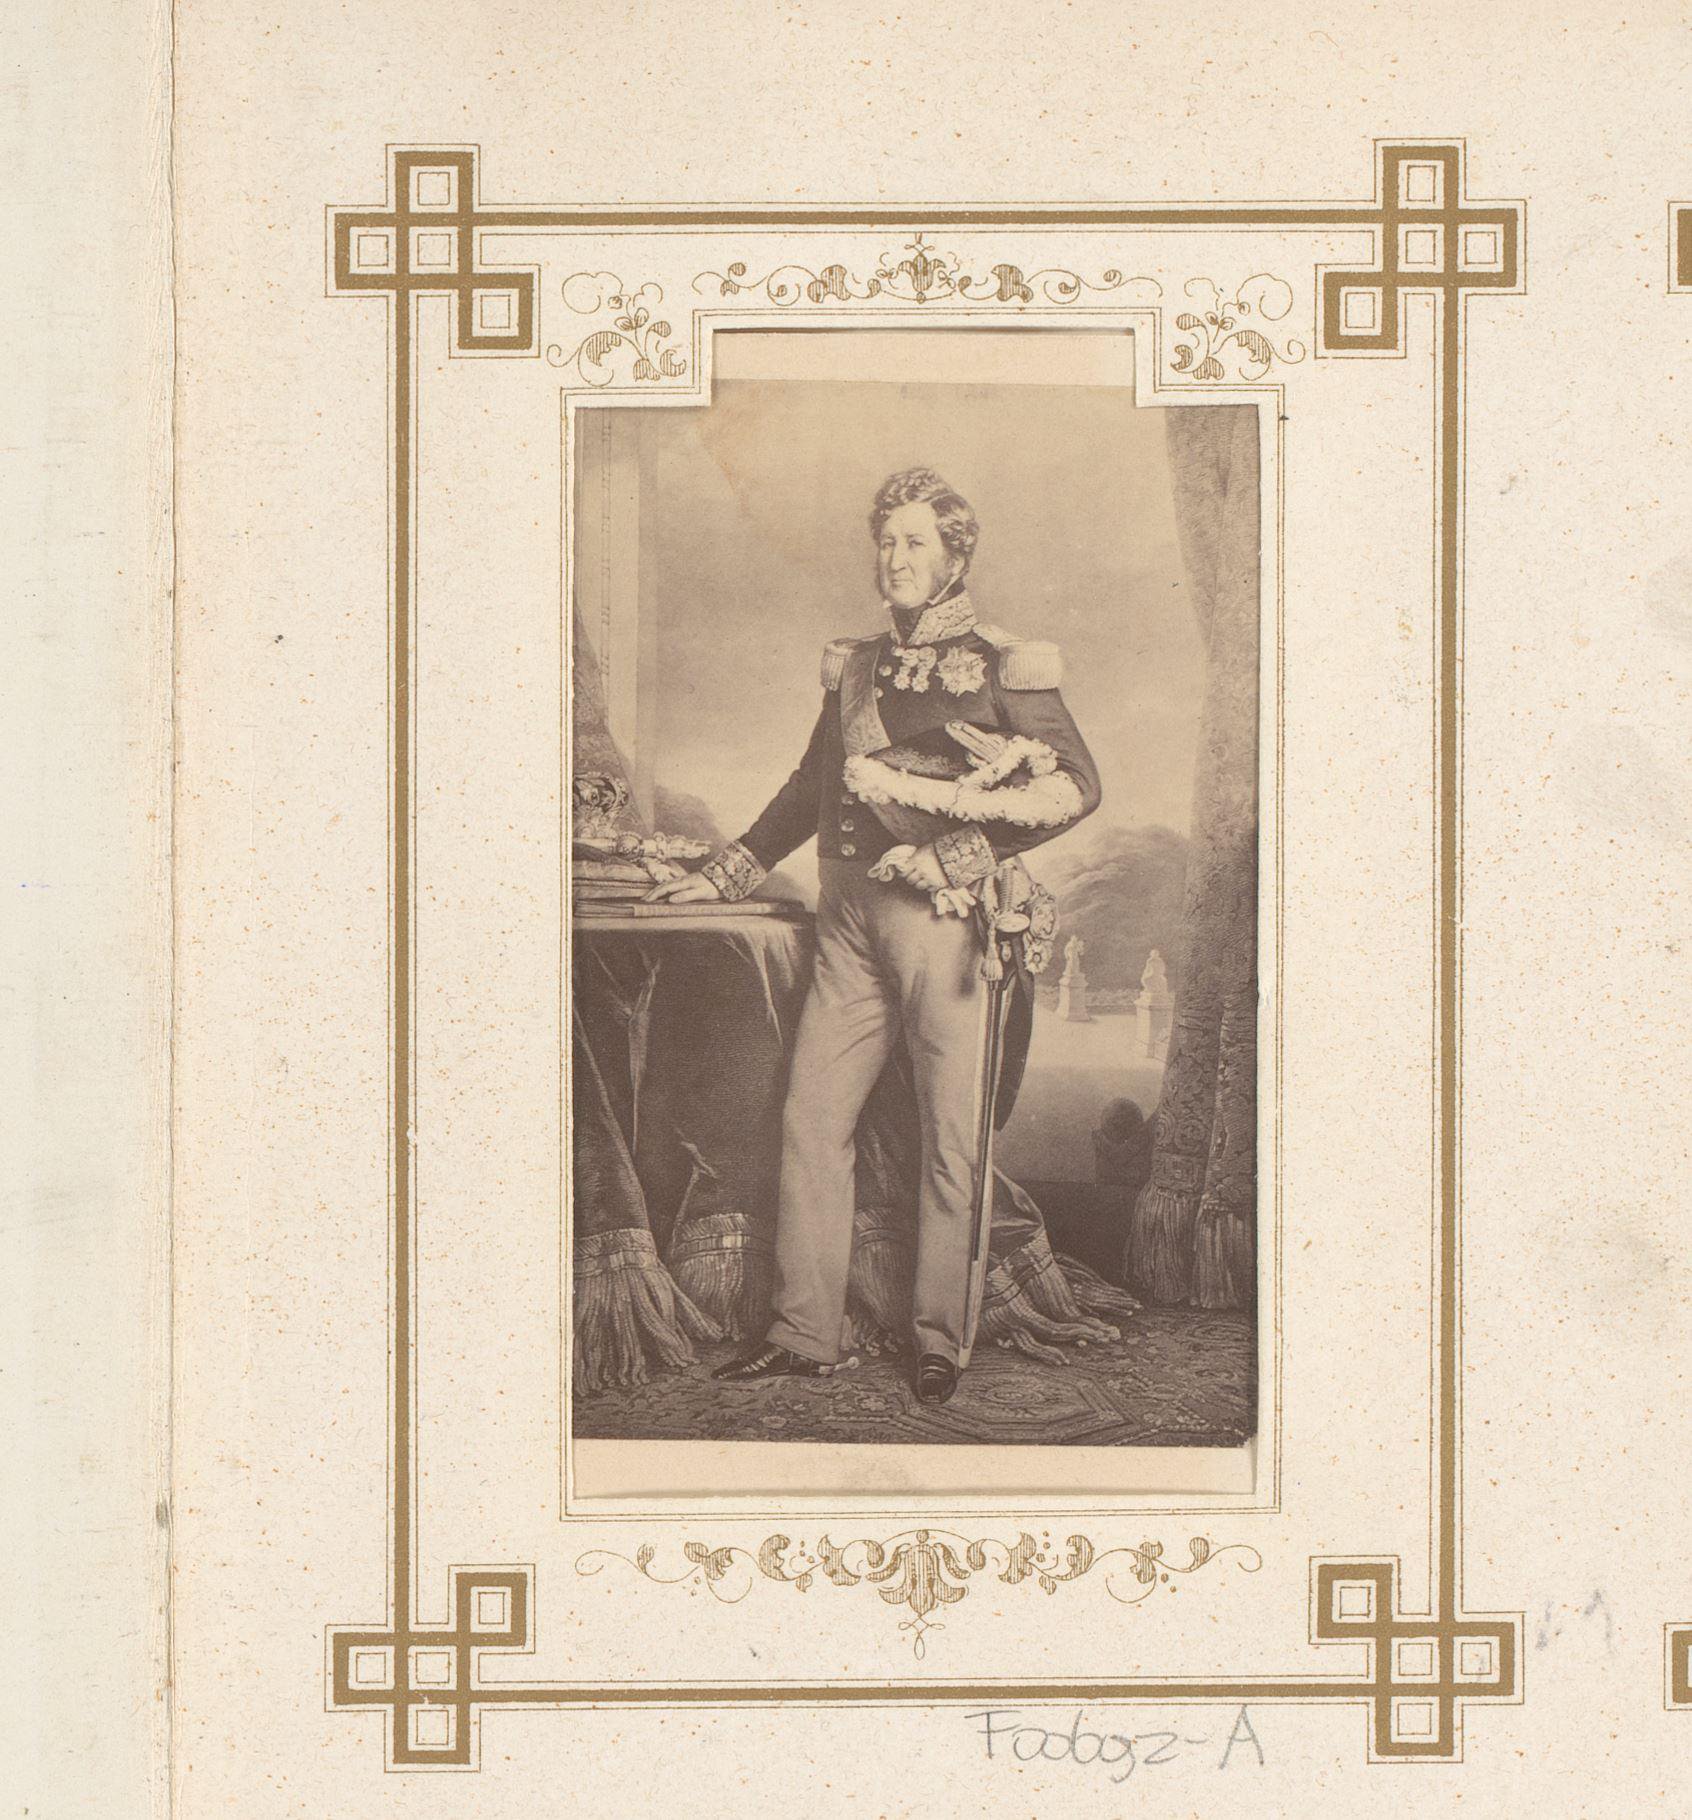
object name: carte de visite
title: Fotoreproductie van een geschilderd portret van koning Lodewijk Filips I van Frankrijk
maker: Anonymous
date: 1855-1890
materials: cardboard, photographic support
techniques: albumen print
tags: paris, lodewijk filips i (koning van frankrijk), historical persons, queen